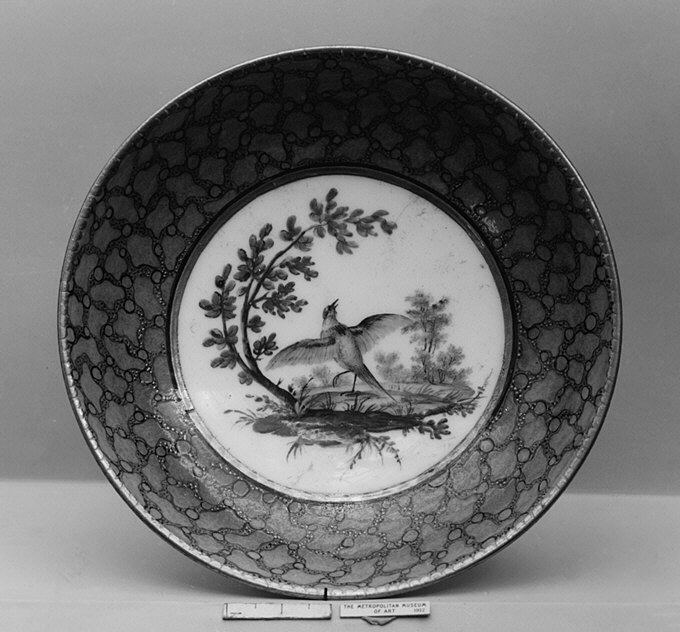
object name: saucer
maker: sèvres manufactory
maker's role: manufactory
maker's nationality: french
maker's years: 1740-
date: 1760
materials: soft paste porcelain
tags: birds,trees